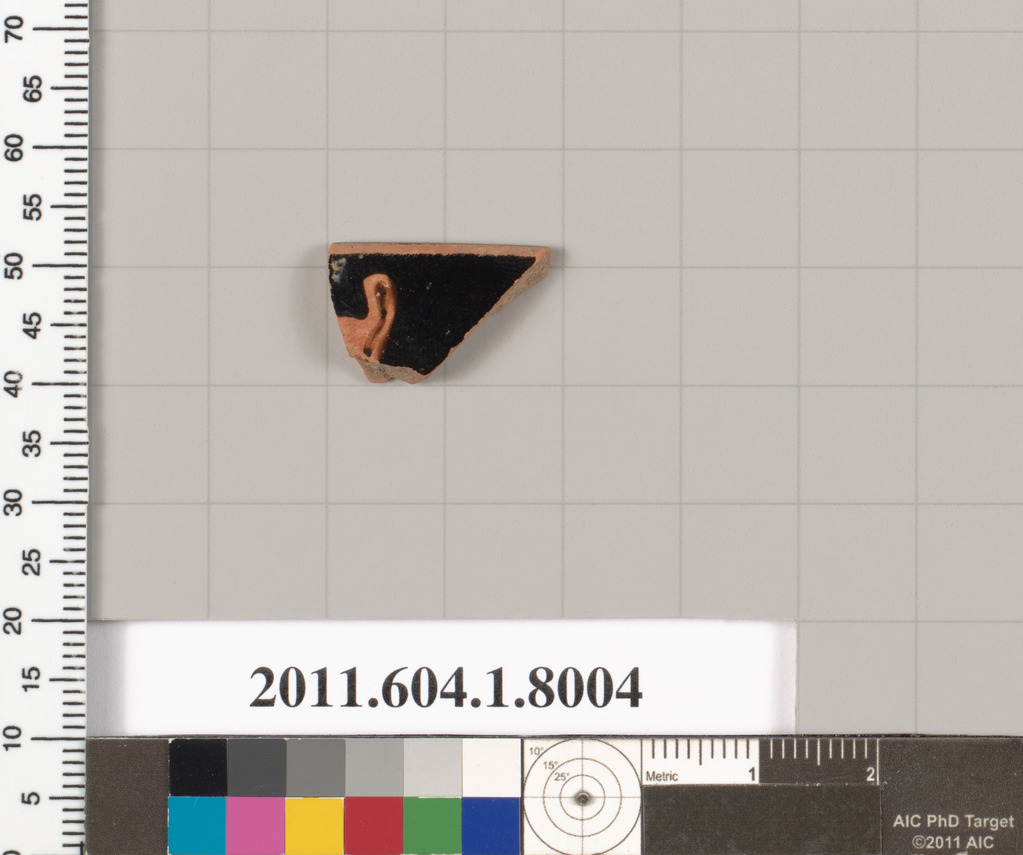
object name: kylix fragment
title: Terracotta rim fragment of a kylix (drinking cup)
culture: greek, attic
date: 460-450 BCE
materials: terracotta